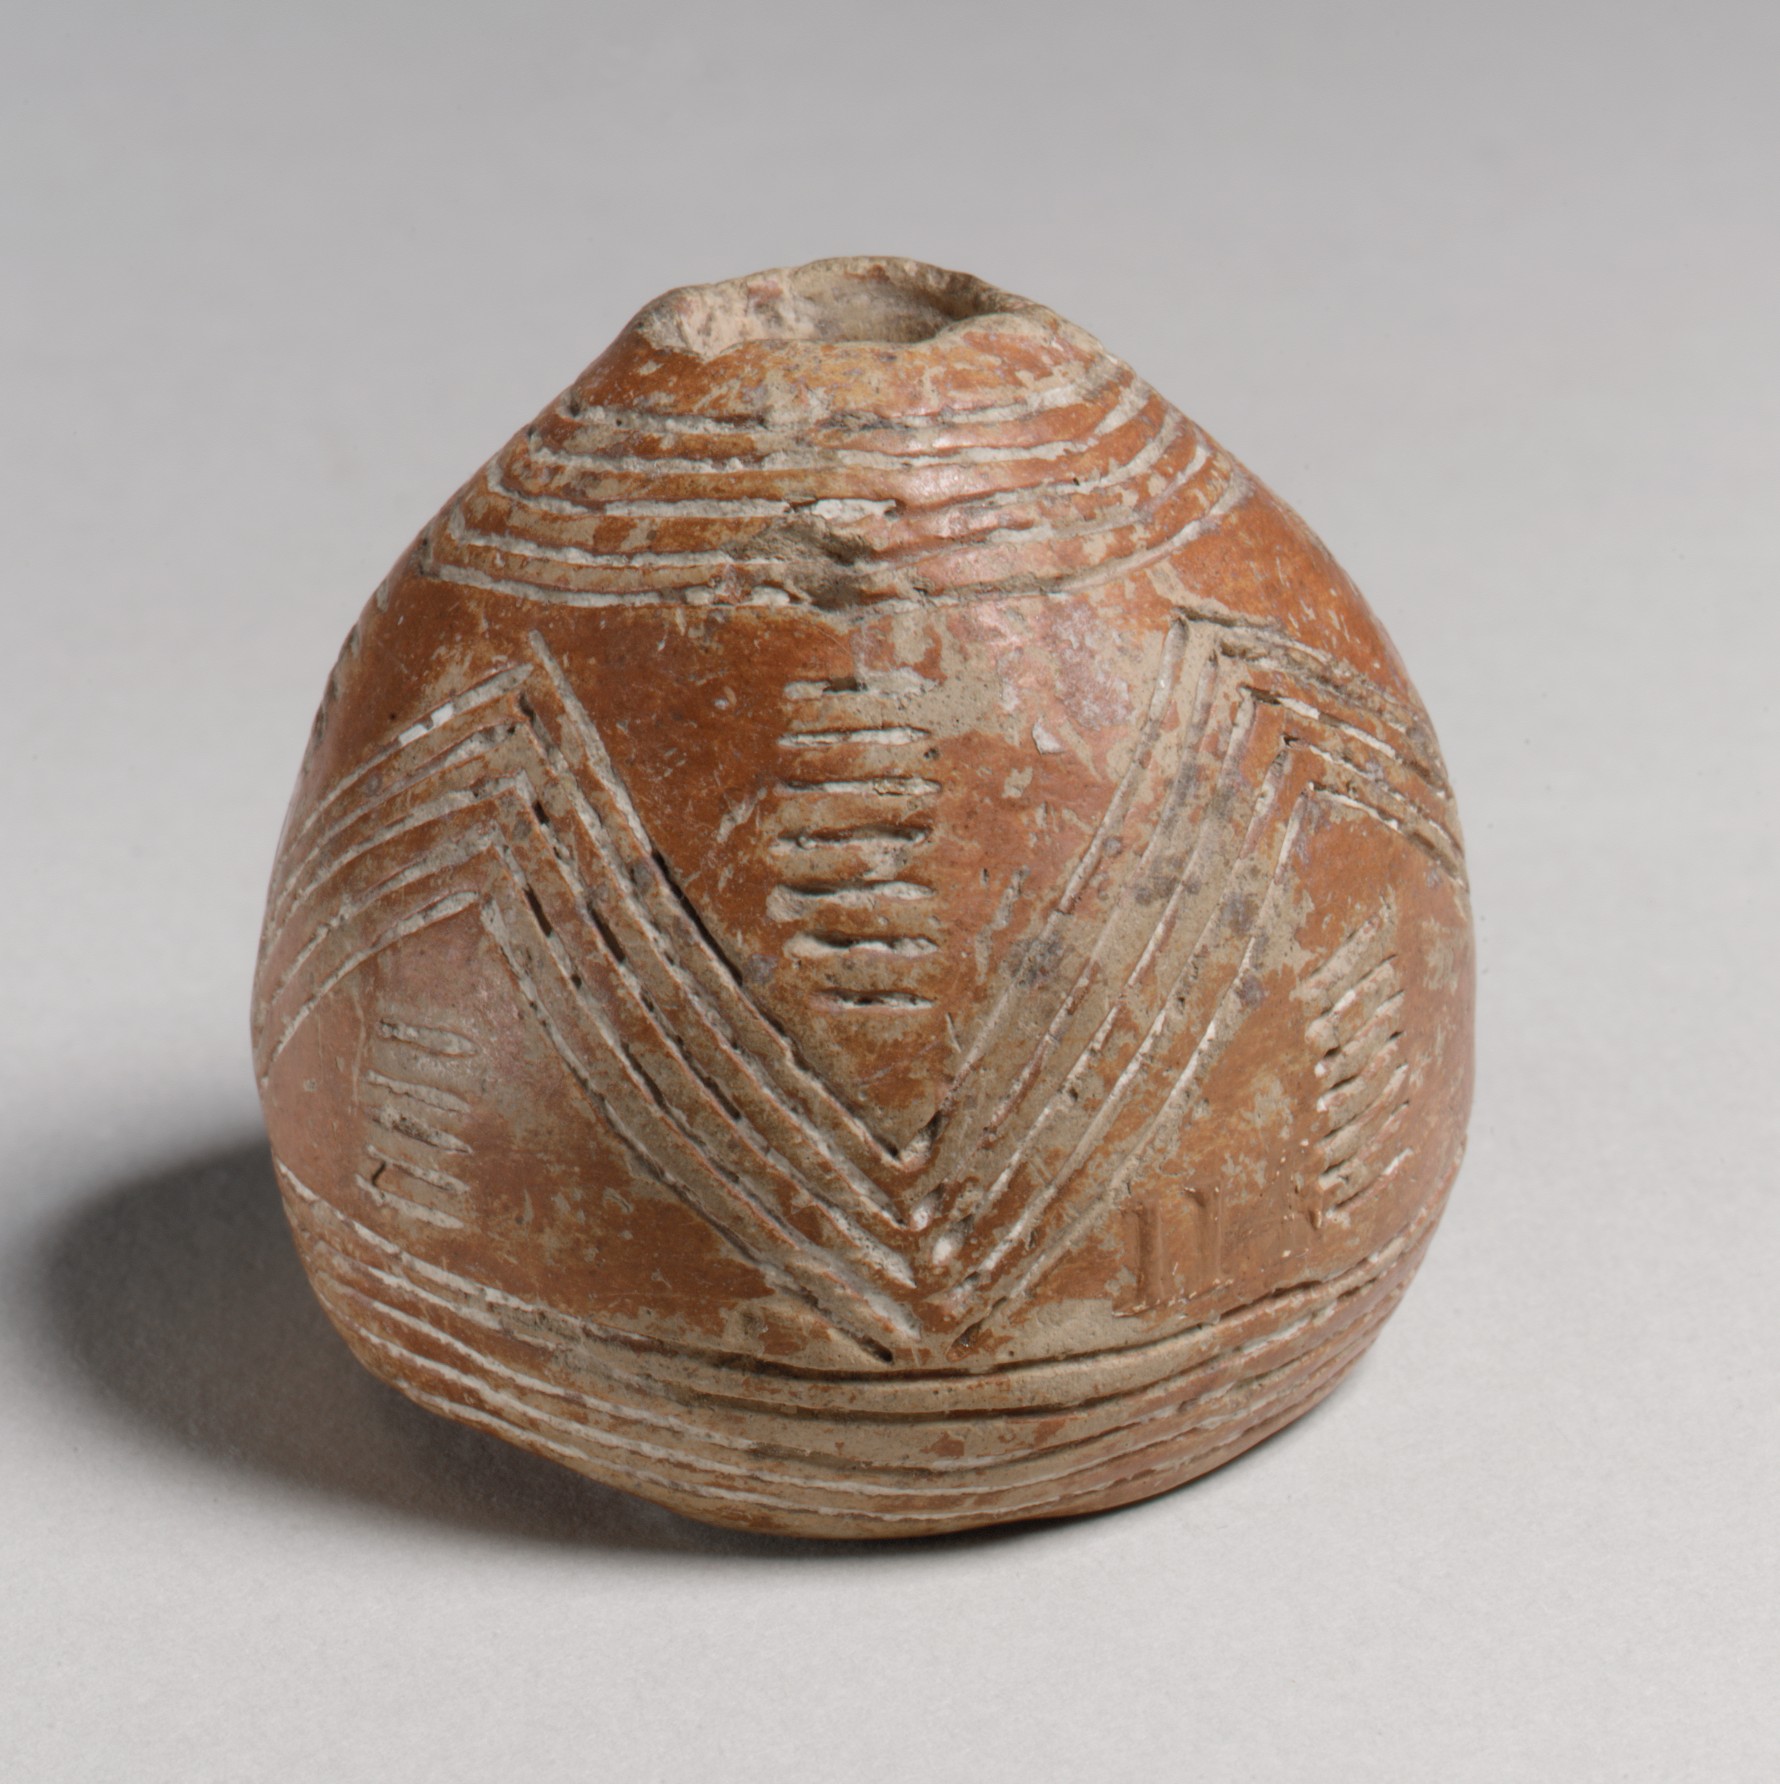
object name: spindle whorl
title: Terracotta spindle whorls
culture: cypriot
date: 2000-1725 BCE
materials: terracotta